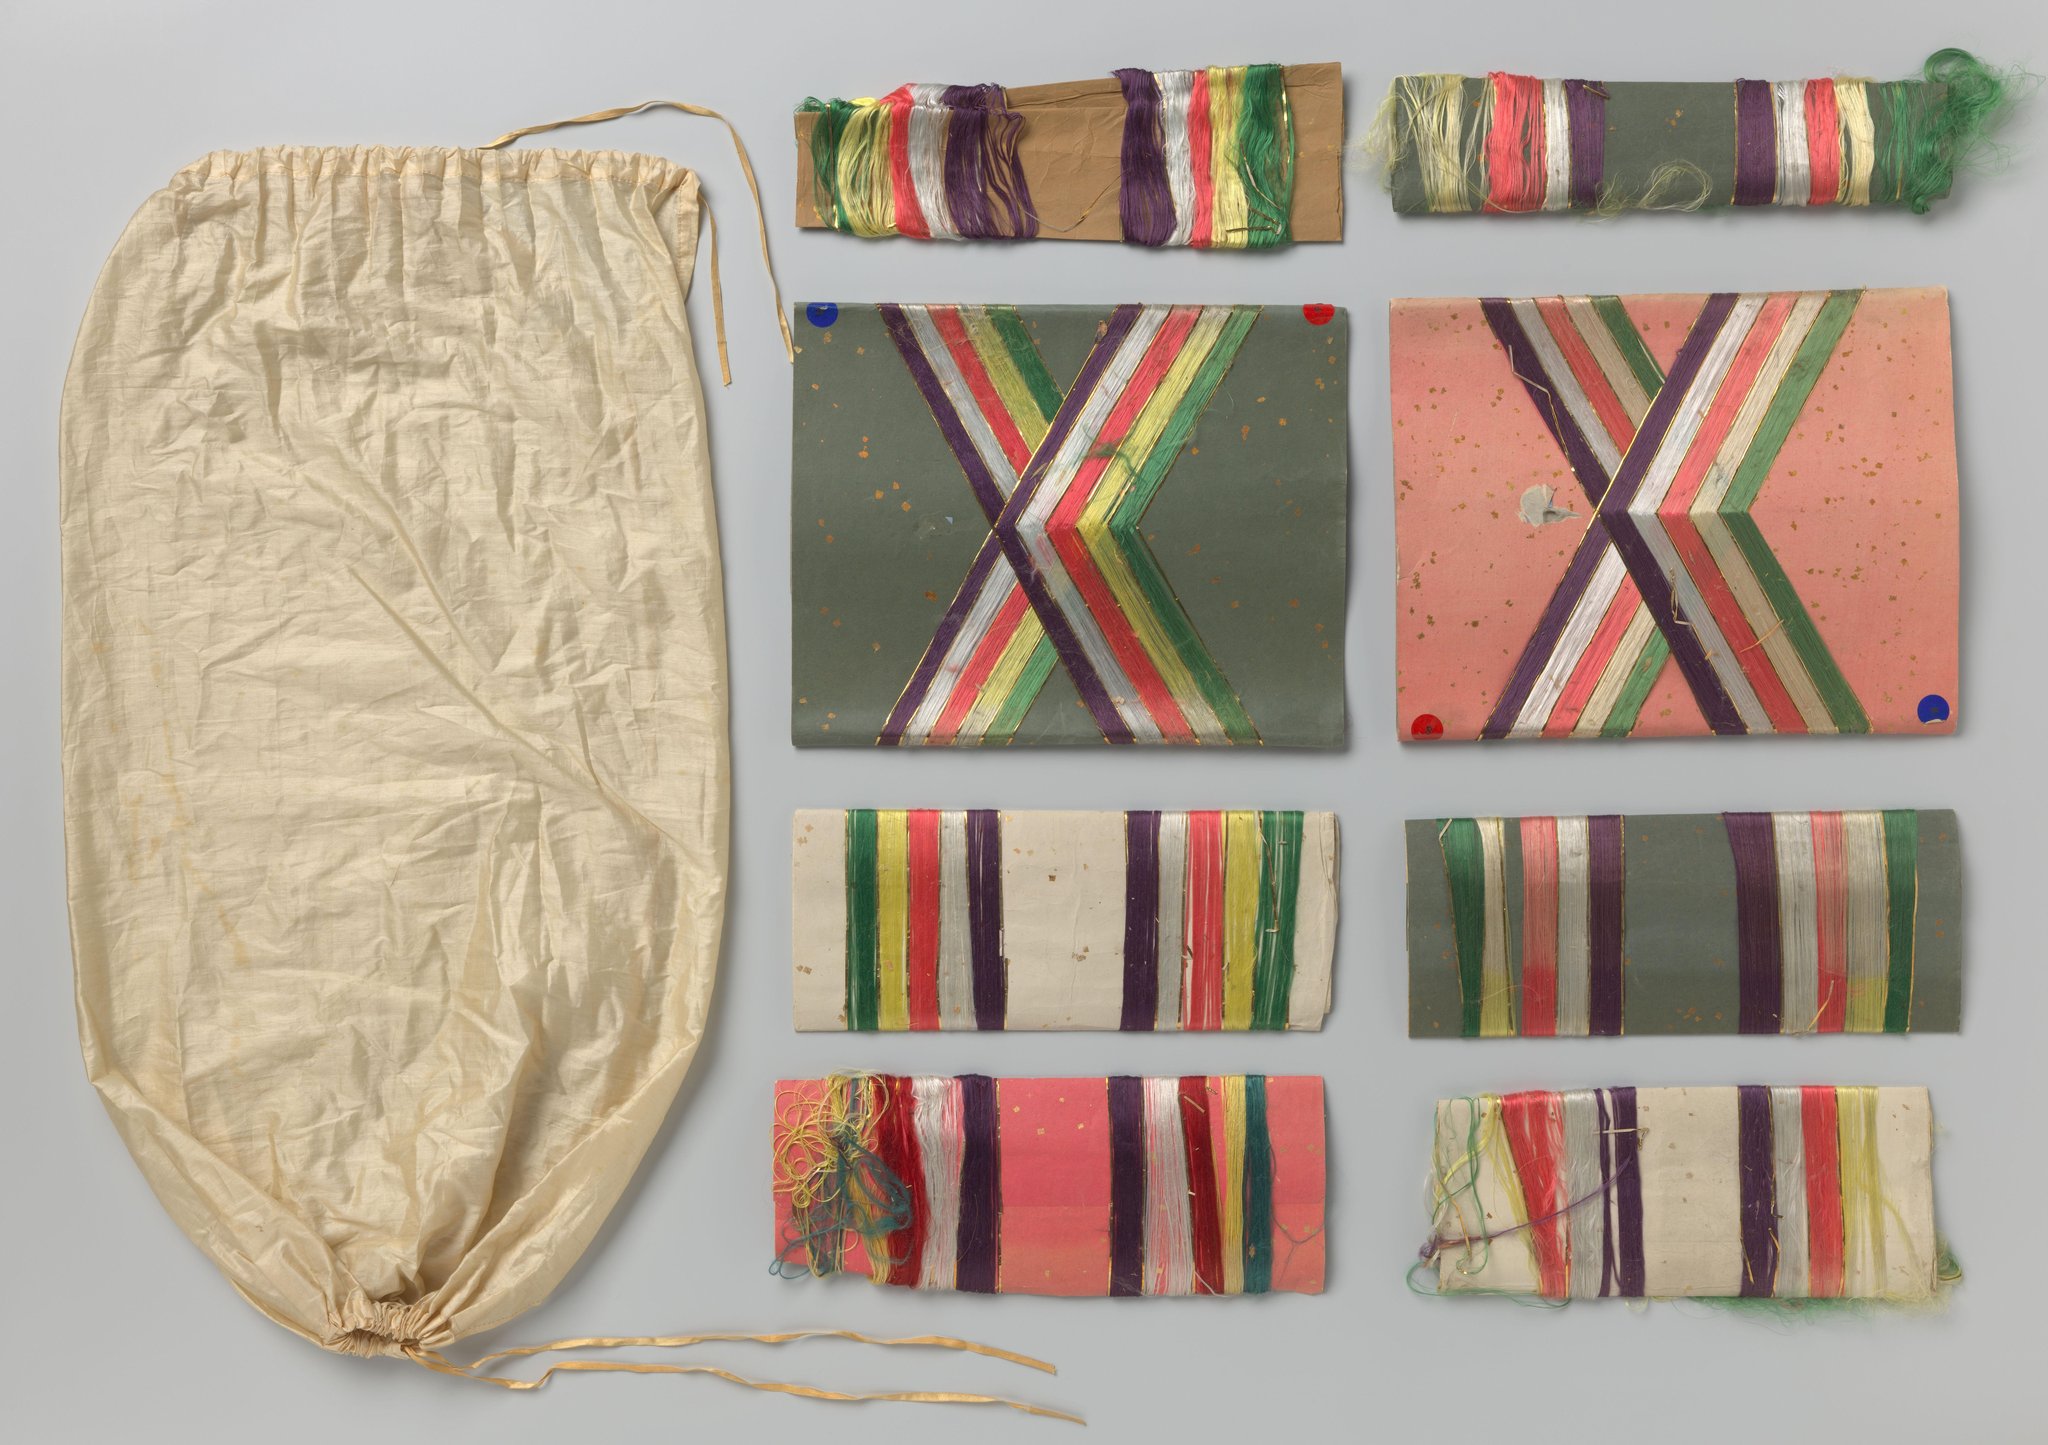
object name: verpakking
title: Onderdeel van originele verpakking van rollen zijde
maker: Anonymous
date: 1900-1920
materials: silk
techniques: weave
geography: japan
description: Zijden opbergzak met aan beide zijden een lint om af te sluiten. Daarbij 8 'kleurenkaarten': kartonnen met gekleurde garens er omheengewikkeld.